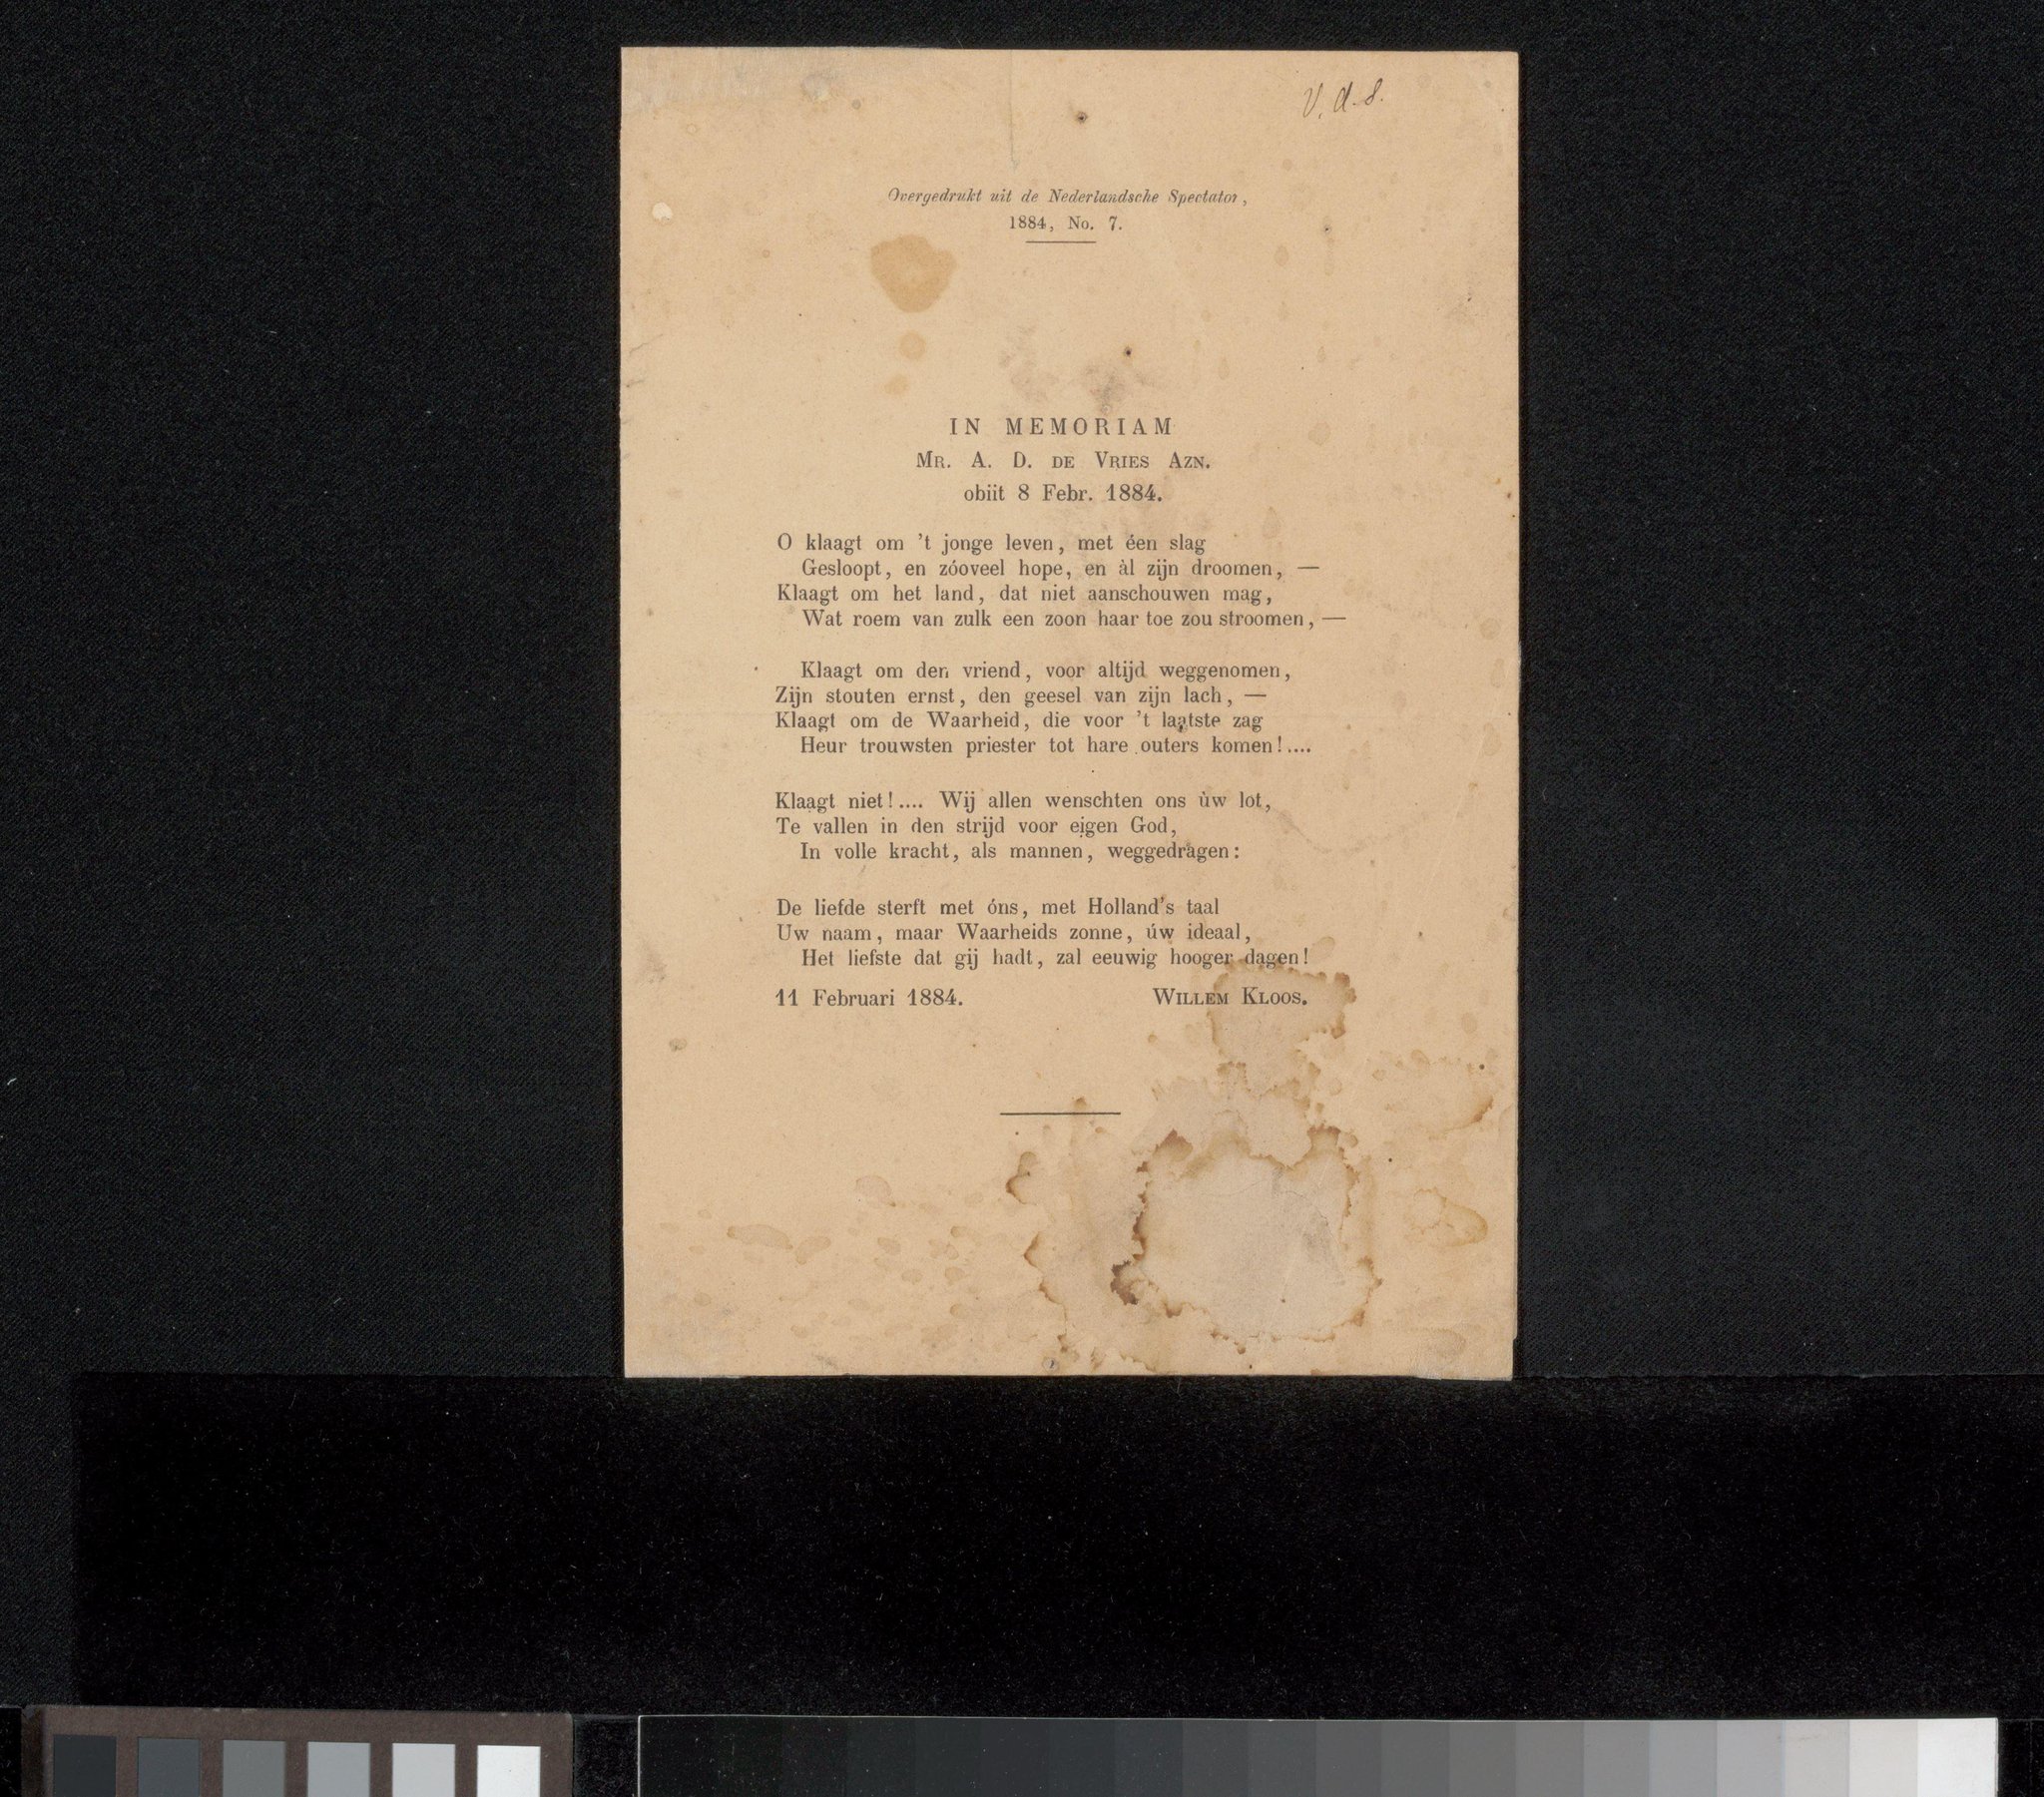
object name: poem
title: In memoriam Adrianus Daniël de Vries uit archief Jan Veth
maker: willem kloos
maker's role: dichter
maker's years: 1859-1938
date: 1884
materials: ink, paper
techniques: printing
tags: dordrecht, amsterdam, painter, draughtsman, designer, jan veth, literature ~ arts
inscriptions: collector's mark: ‘RPK’